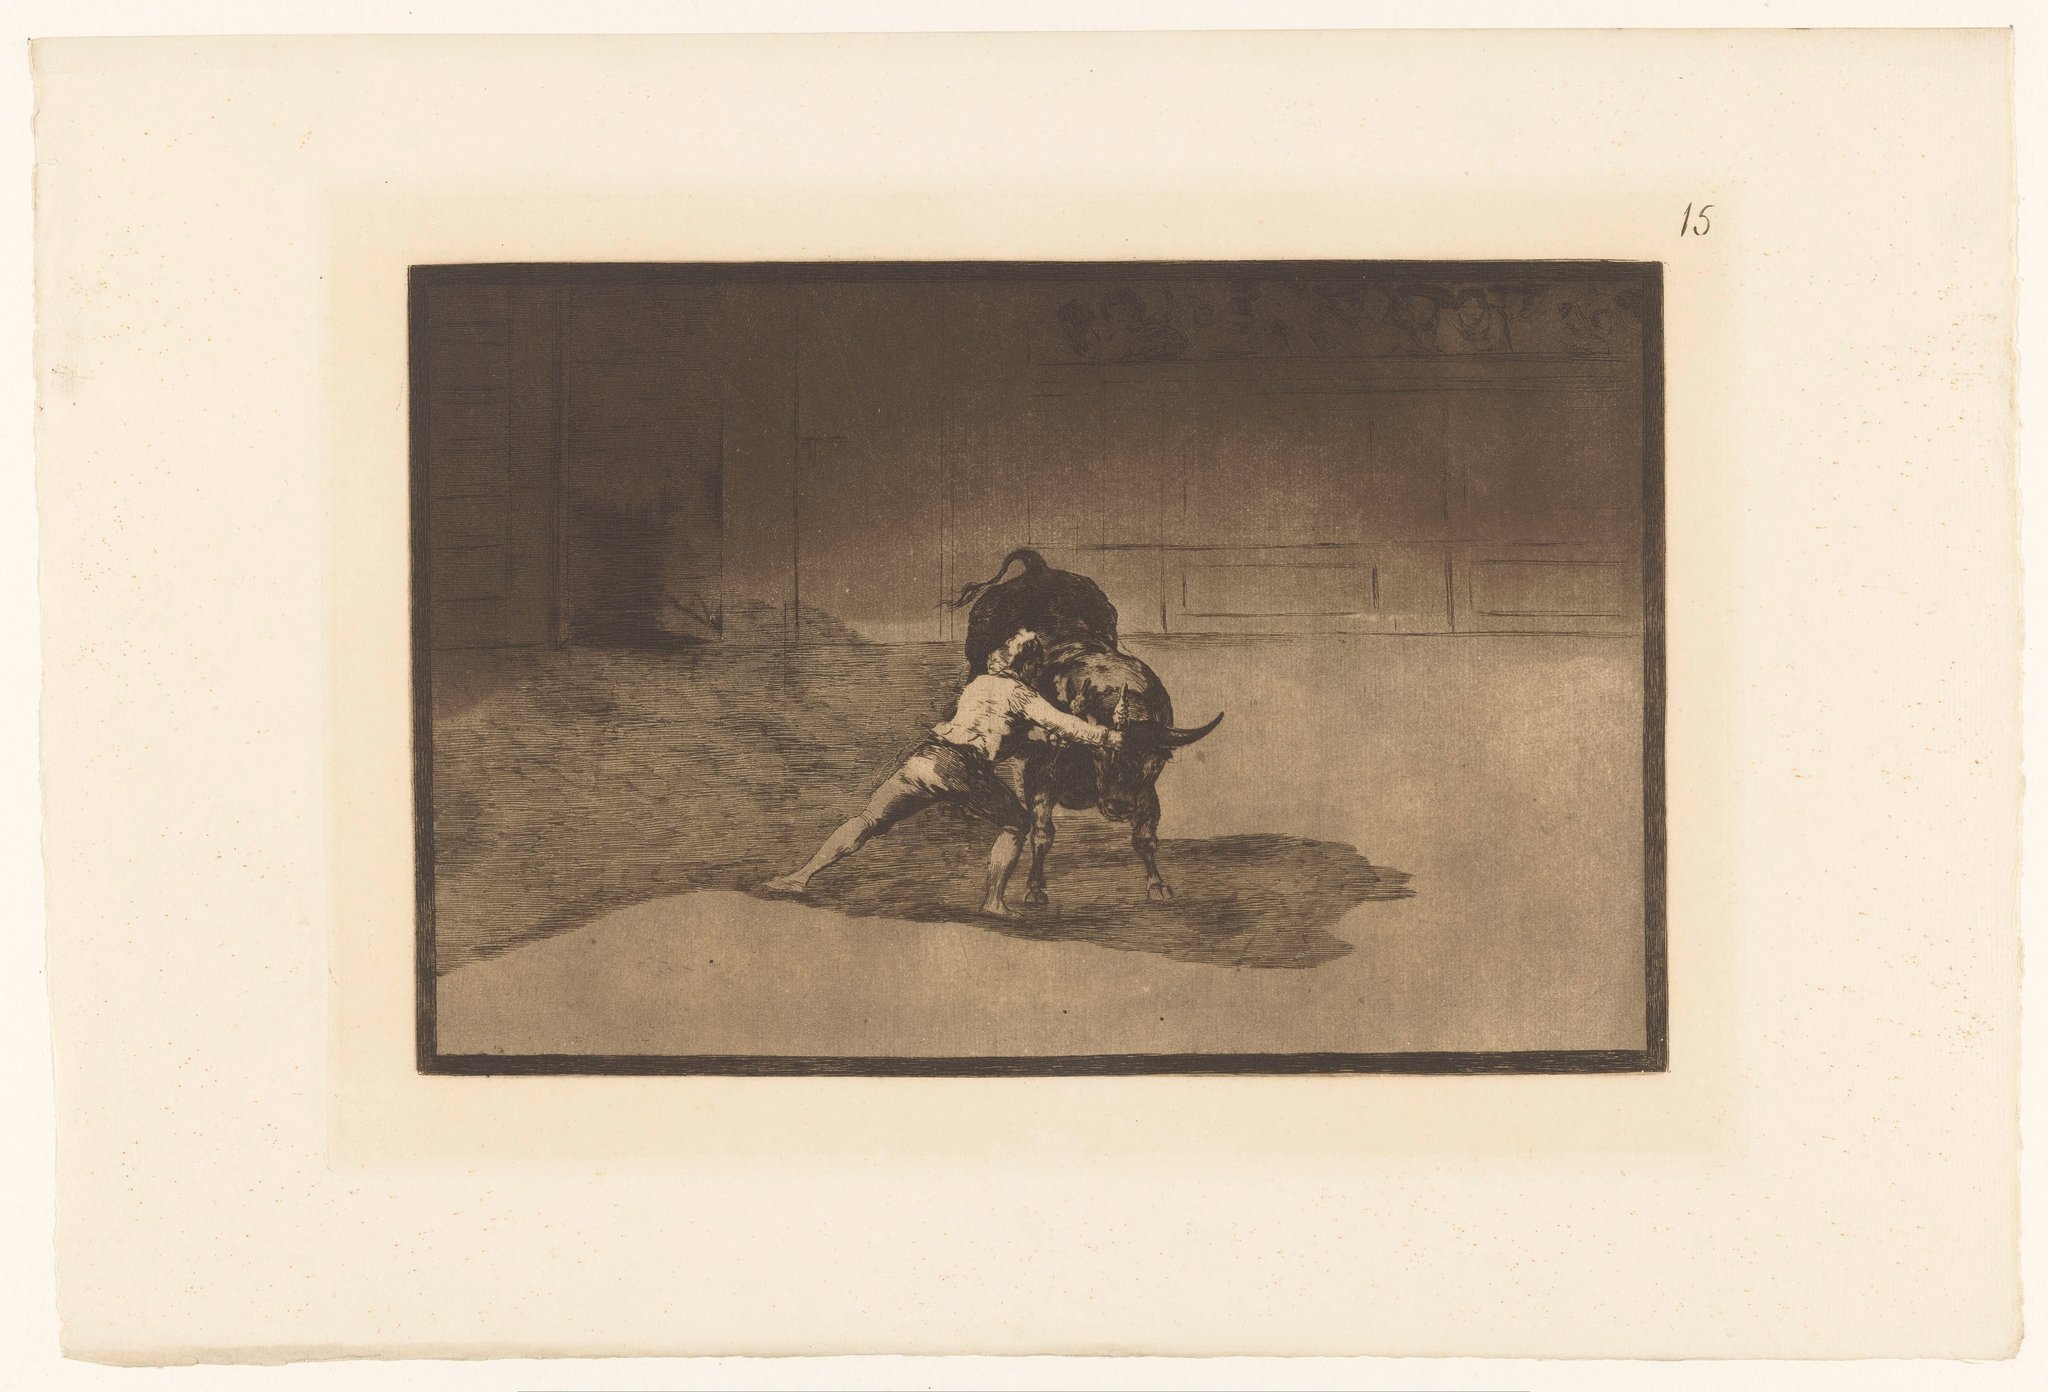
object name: print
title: La Taureaumachie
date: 1876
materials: paper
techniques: aquatint, etching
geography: paris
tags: bullfight, bull-fighter, toreador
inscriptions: collector's mark: Lugt 2228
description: Deze prent maakt deel uit van een serie van 40 prenten door Francisco de Goya met voorstellingen van stierengevechten. De eerste editie bestond uit 33 genummerde prenten en werd uitgegeven in 1816. Dit betreft de derde editie, uitgegeven in 1876 door Eugène Loizelet en door hem voorzien van een titelprent en lijst met titels. Naast de 33 prenten publiceerde Loizelet ook de prenten die door Goya op de achterkanten van 7 van de platen werden geëtst. Deze zijn niet voorzien van nummers maar van de letters A-G.